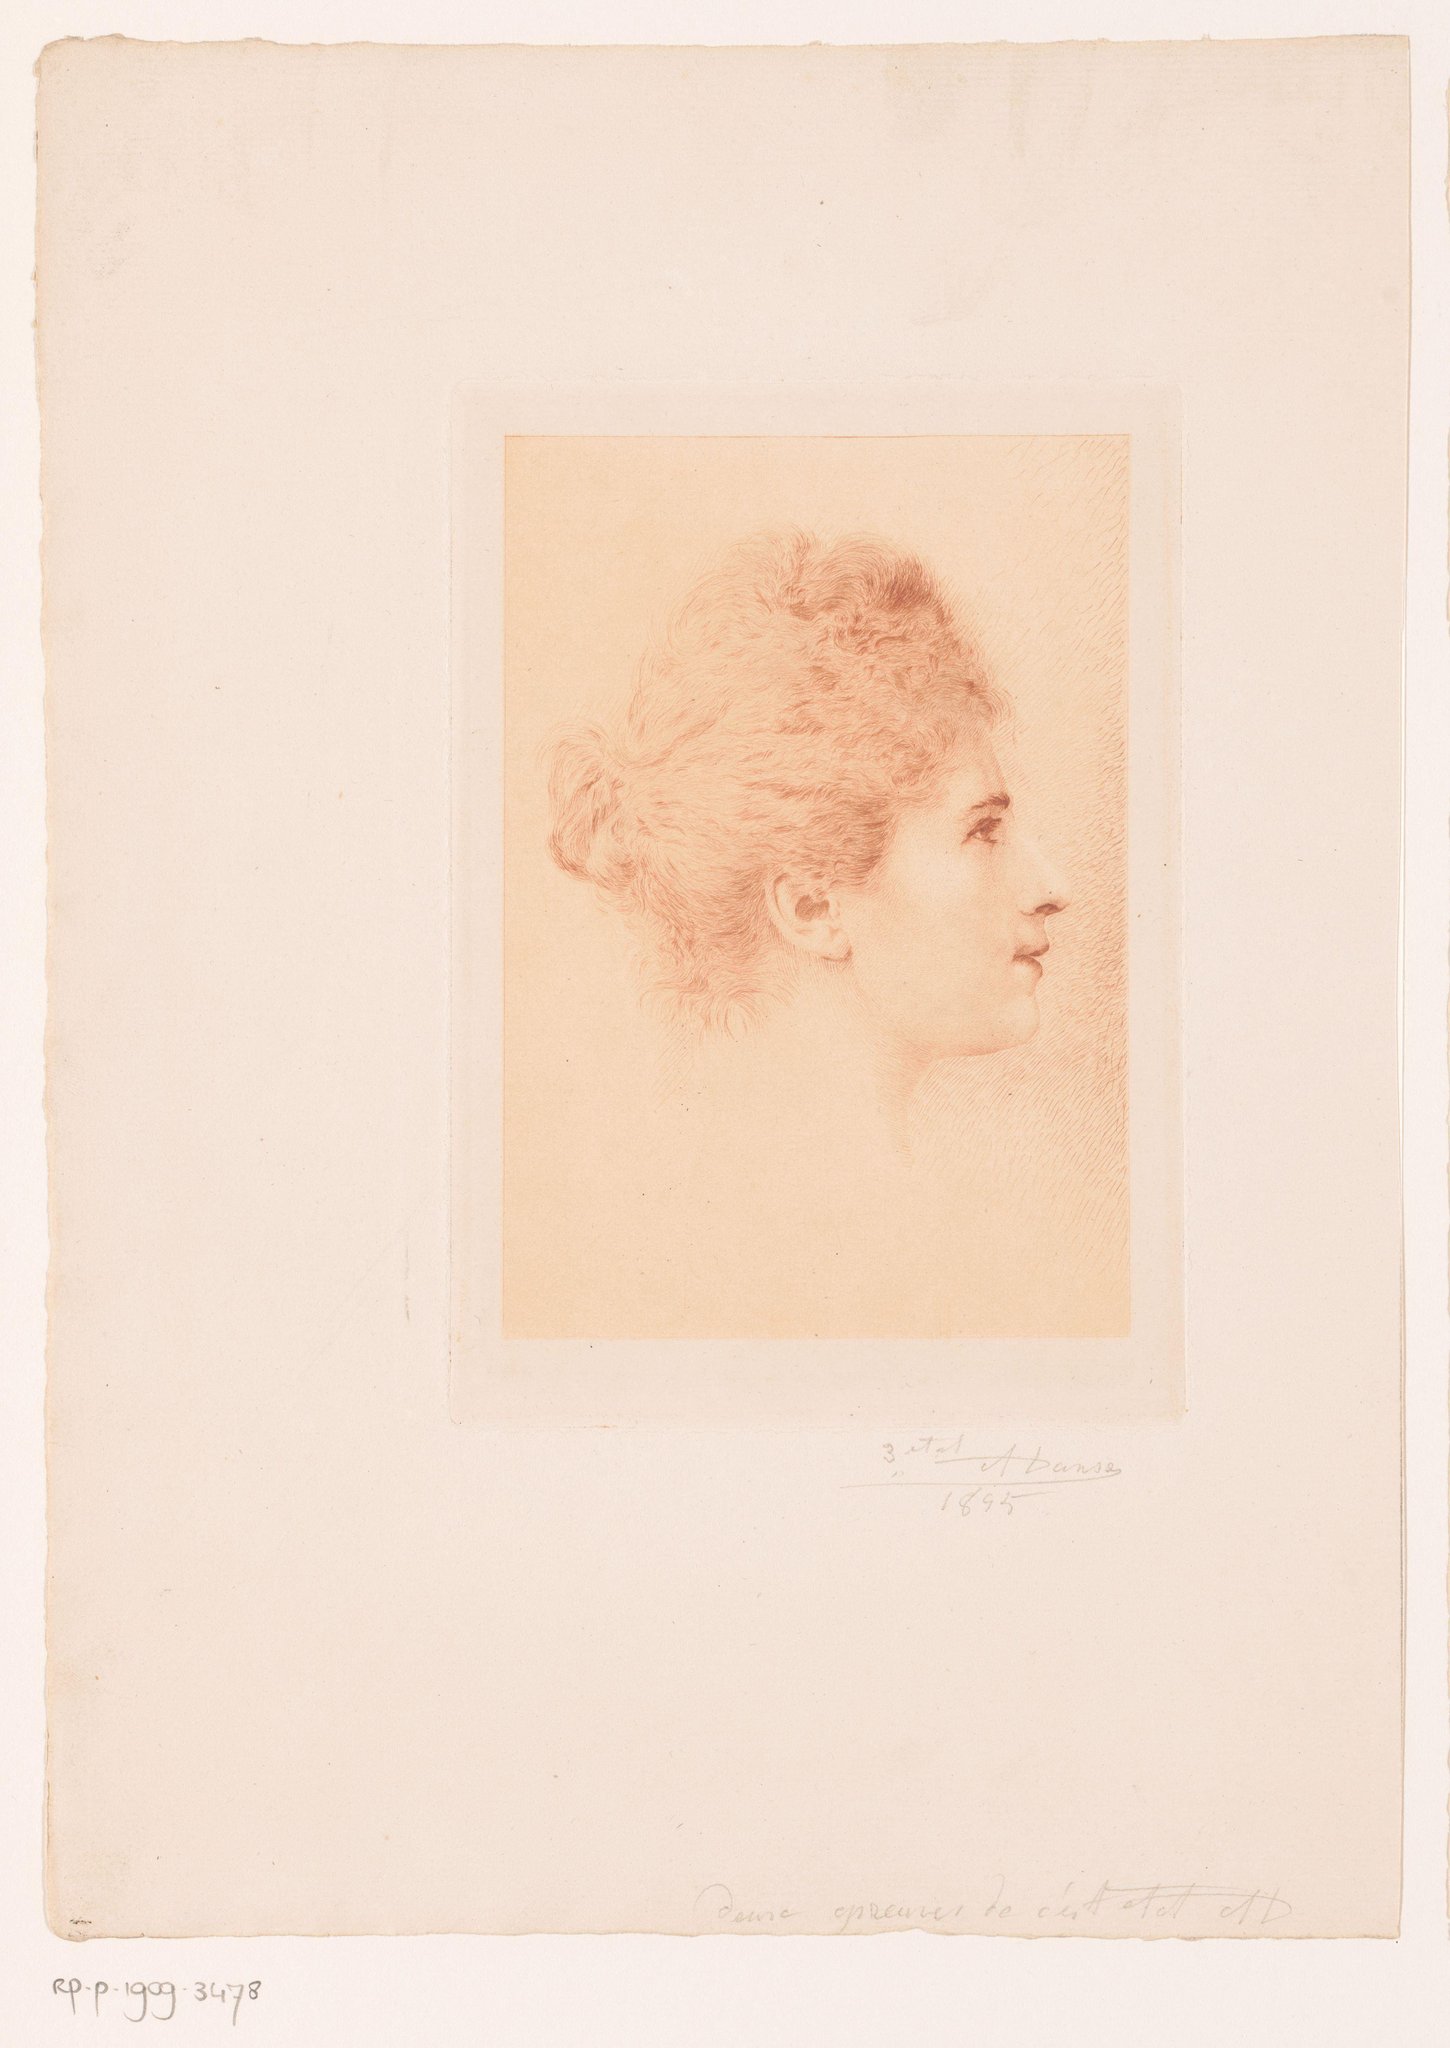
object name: print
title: Portret van Louise Danse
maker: auguste danse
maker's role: print maker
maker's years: 1829-1929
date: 1895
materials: paper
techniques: etching, intaglio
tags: brussels, painter, print maker, louise danse, portrait, self-portrait of artist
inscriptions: collector's mark: Lugt 2228, annotation: ‘3 etat; deux epreuves de c'est etat’, watermark: ‘MBM’